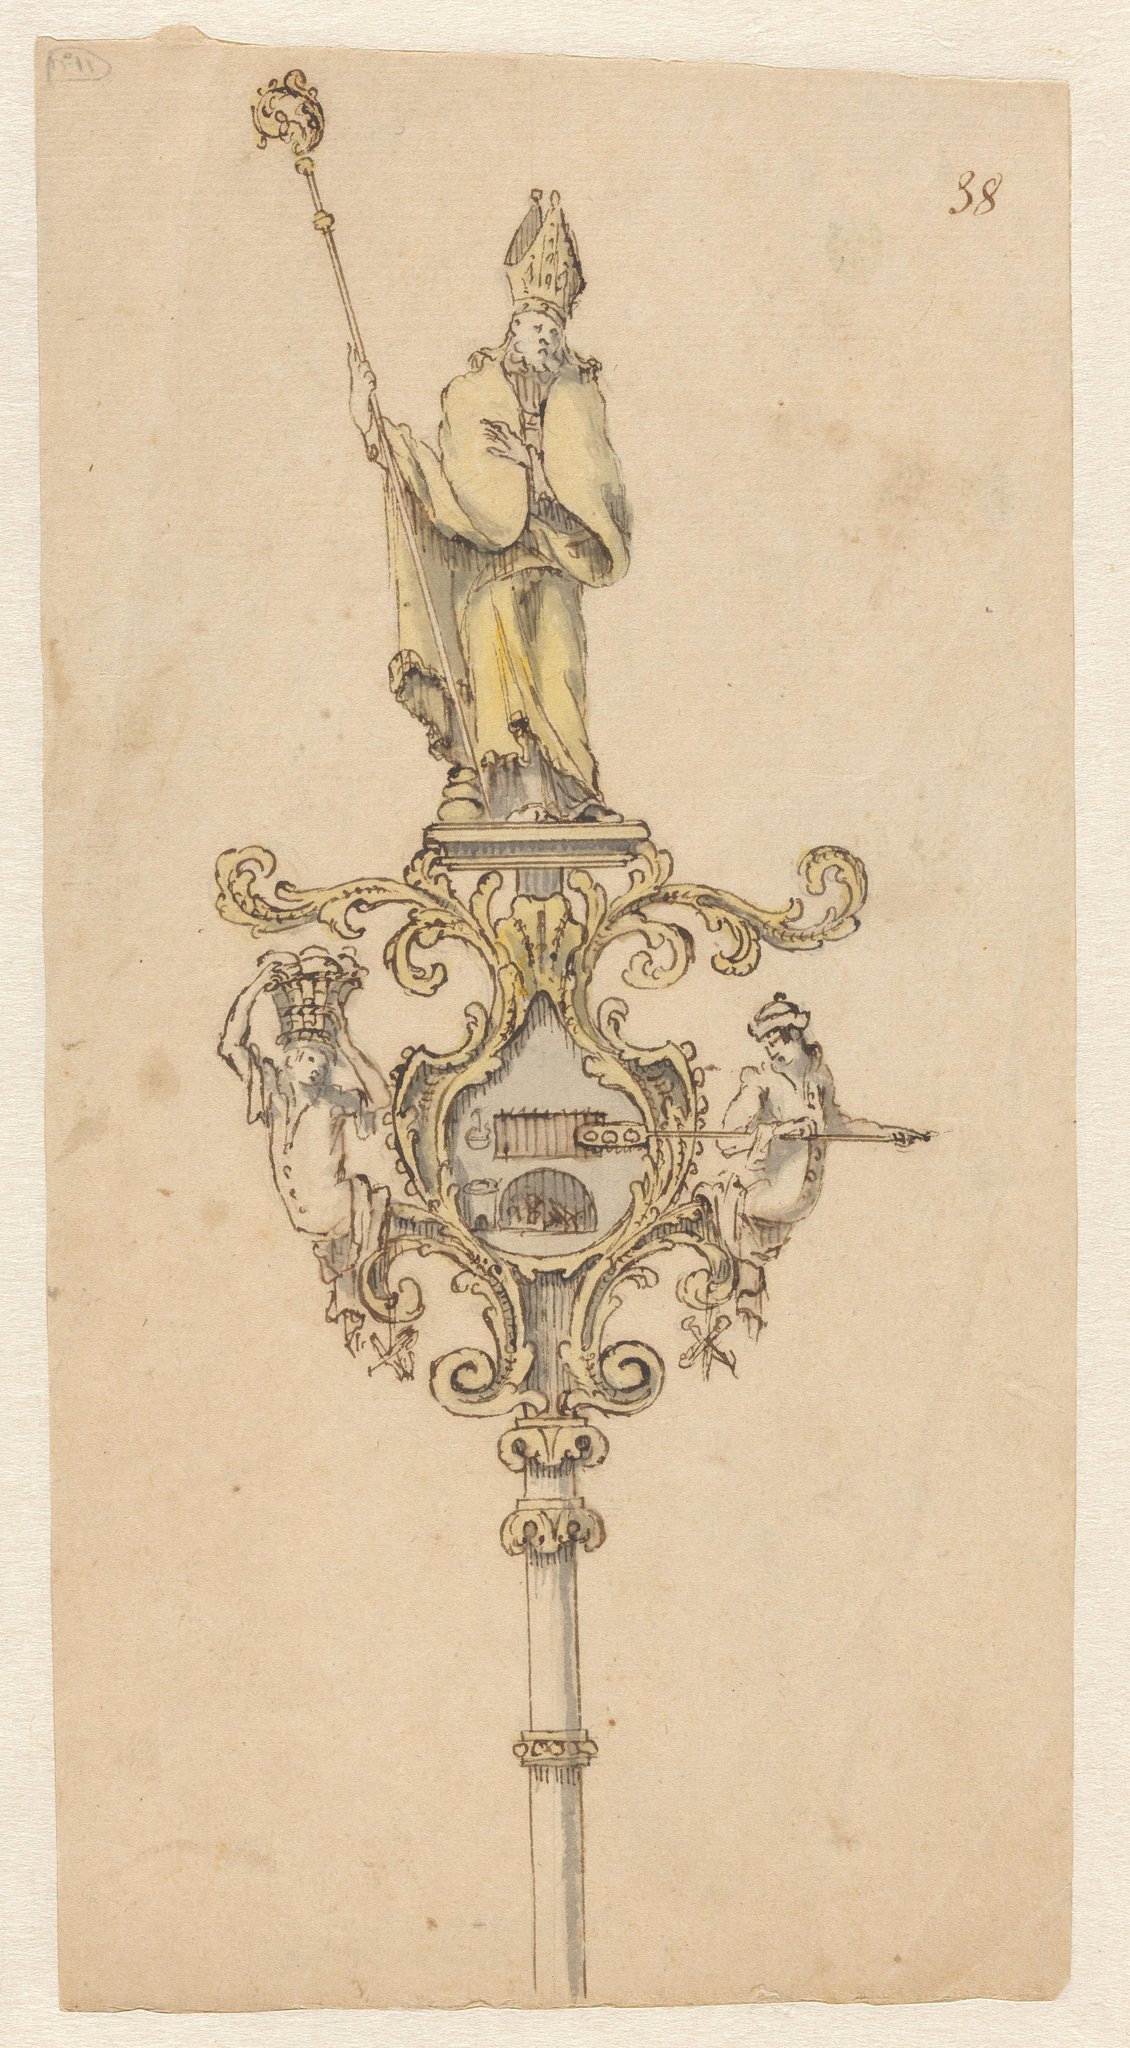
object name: design drawing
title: Ontwerp voor een draagteken van een broodbakkersgilde, met de Heilige Honoratus van Amiens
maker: Anonymous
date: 1720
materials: chalk, ink, paper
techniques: brush, pen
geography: brussels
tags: medal, badge of a guild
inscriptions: number: ‘38’, collector's mark: ‘V.’ Lugt 567